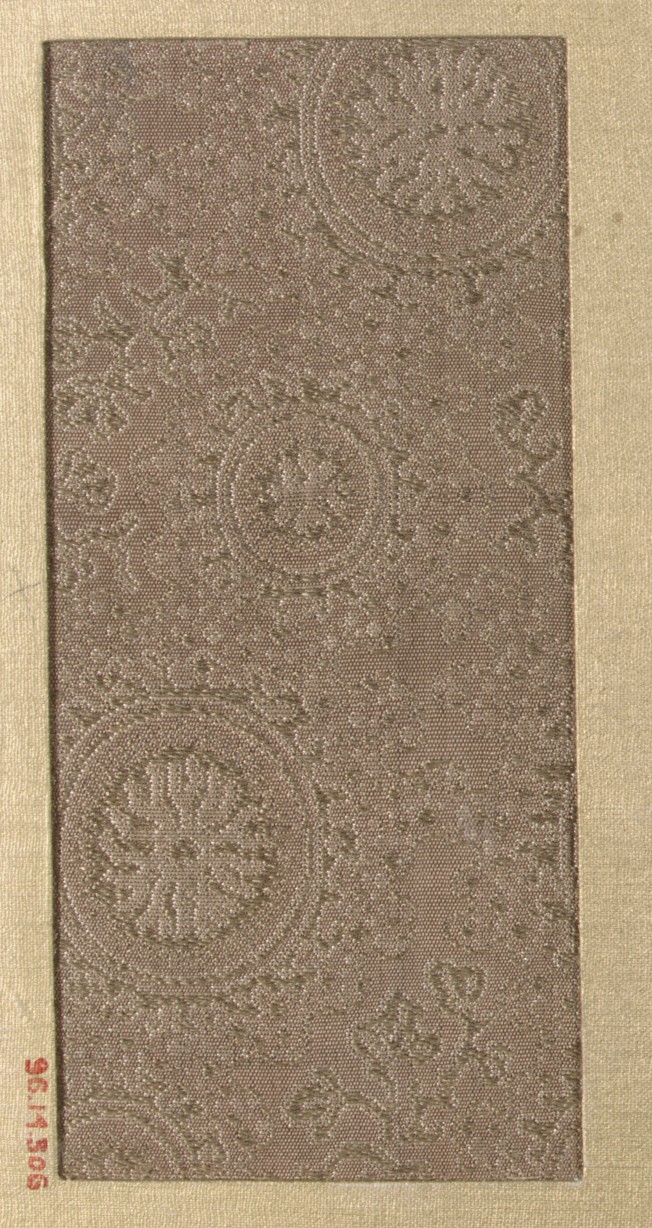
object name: piece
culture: japanese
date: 1701-1900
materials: silk